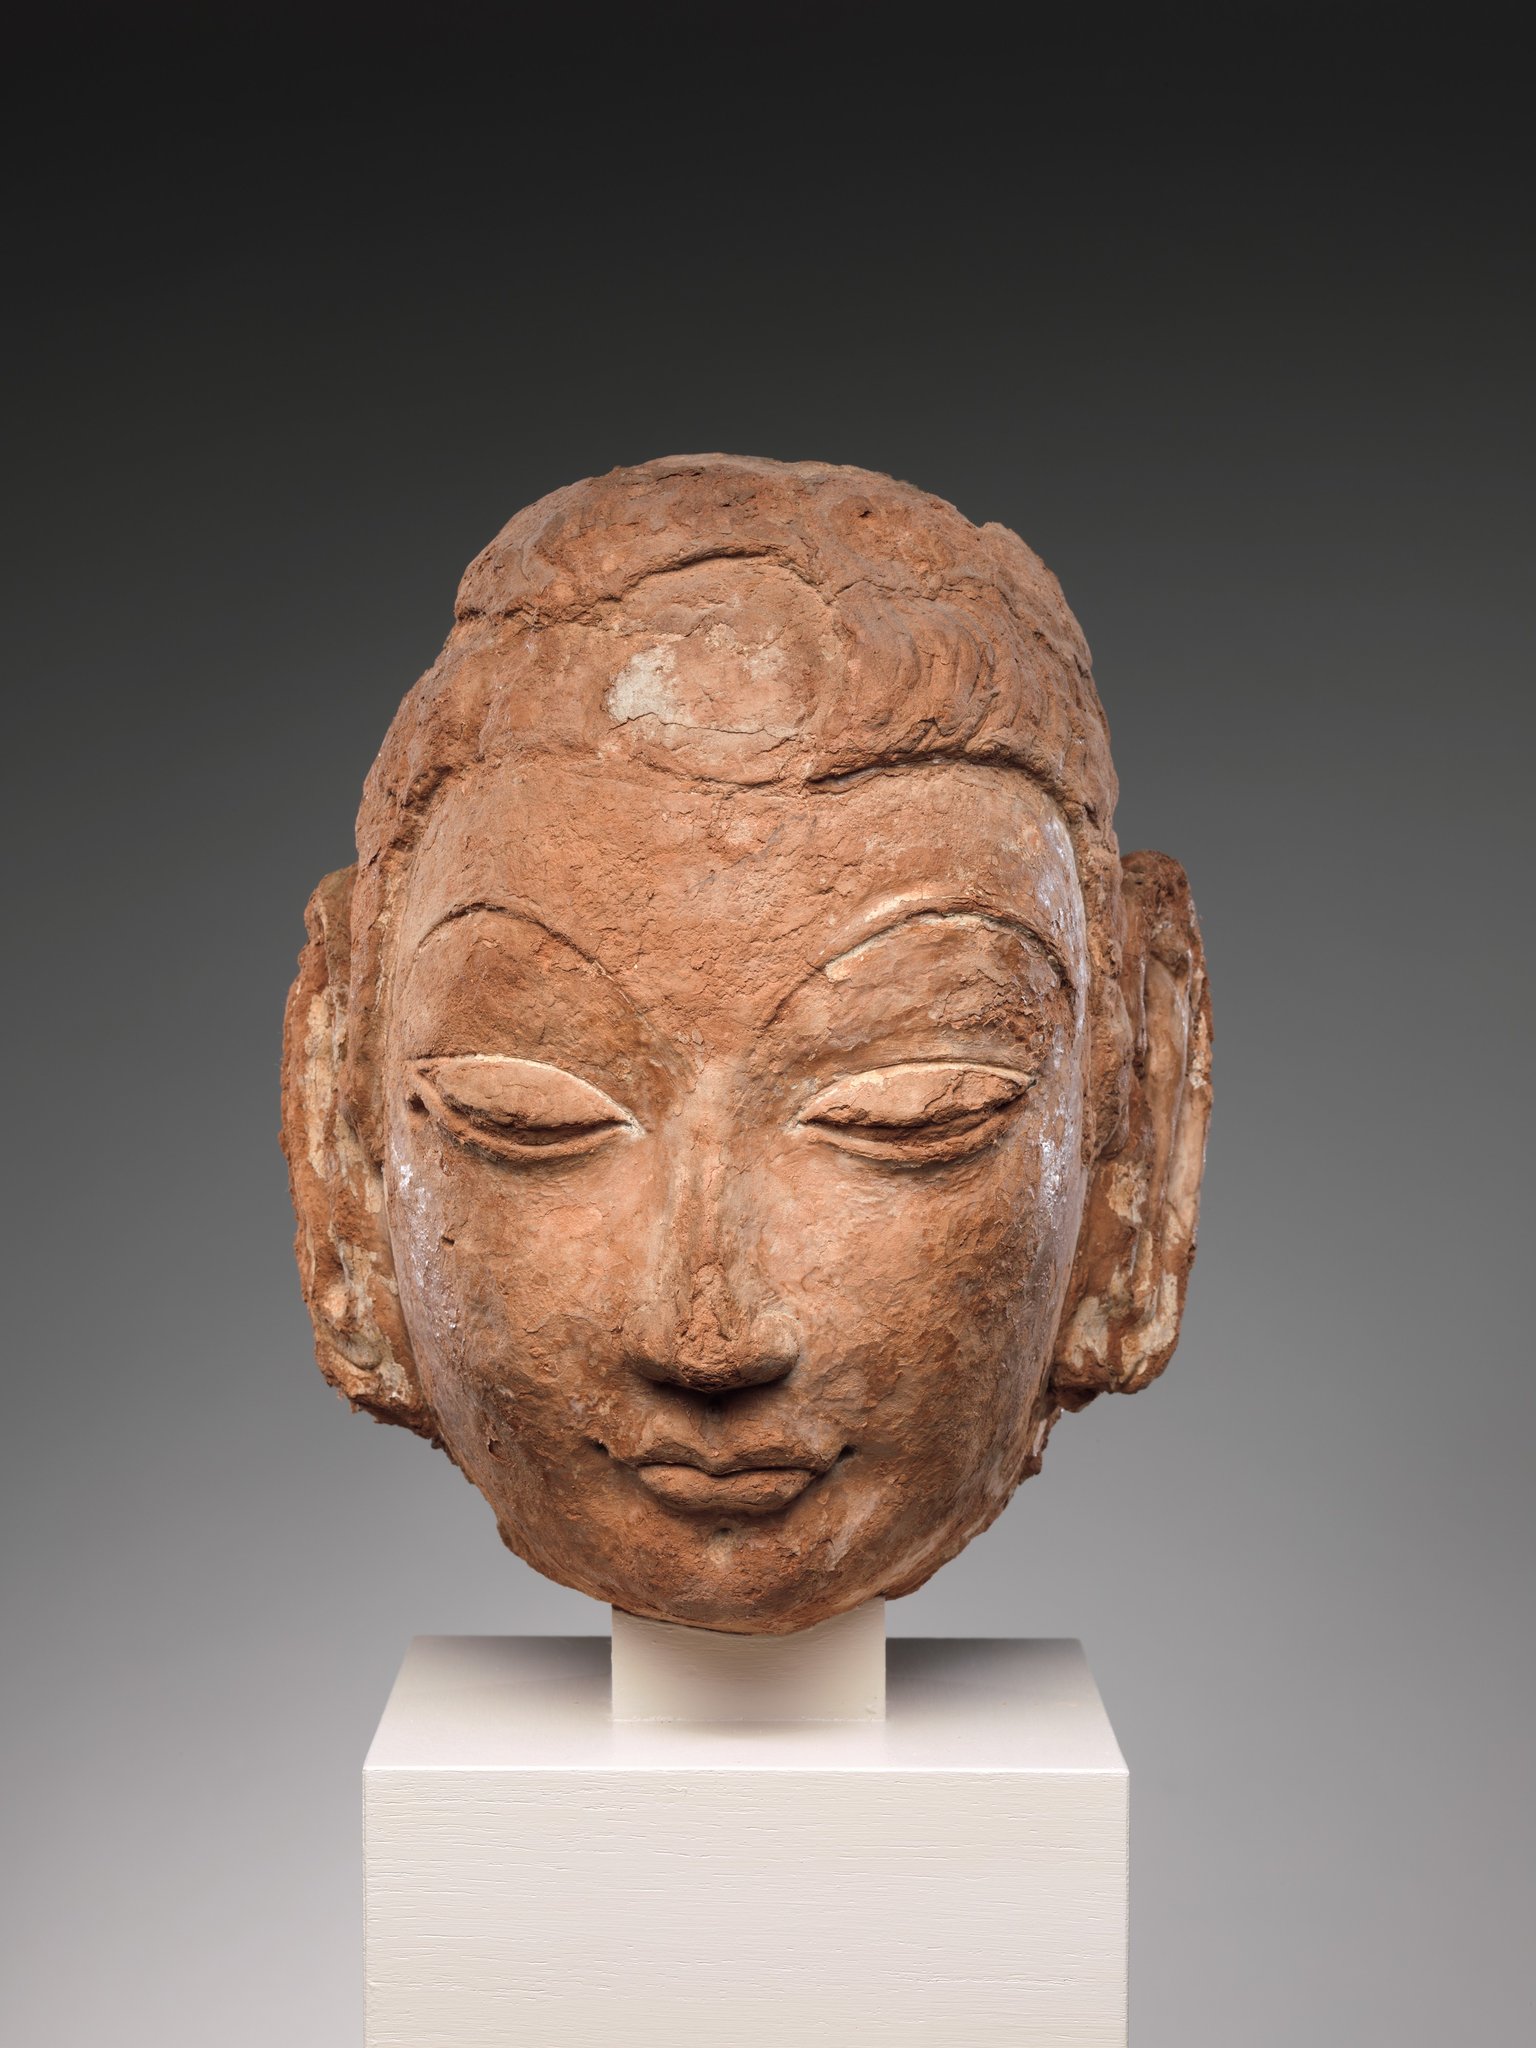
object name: head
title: Head of Buddha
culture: chinese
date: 501-700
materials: clay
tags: heads,buddhism,buddha